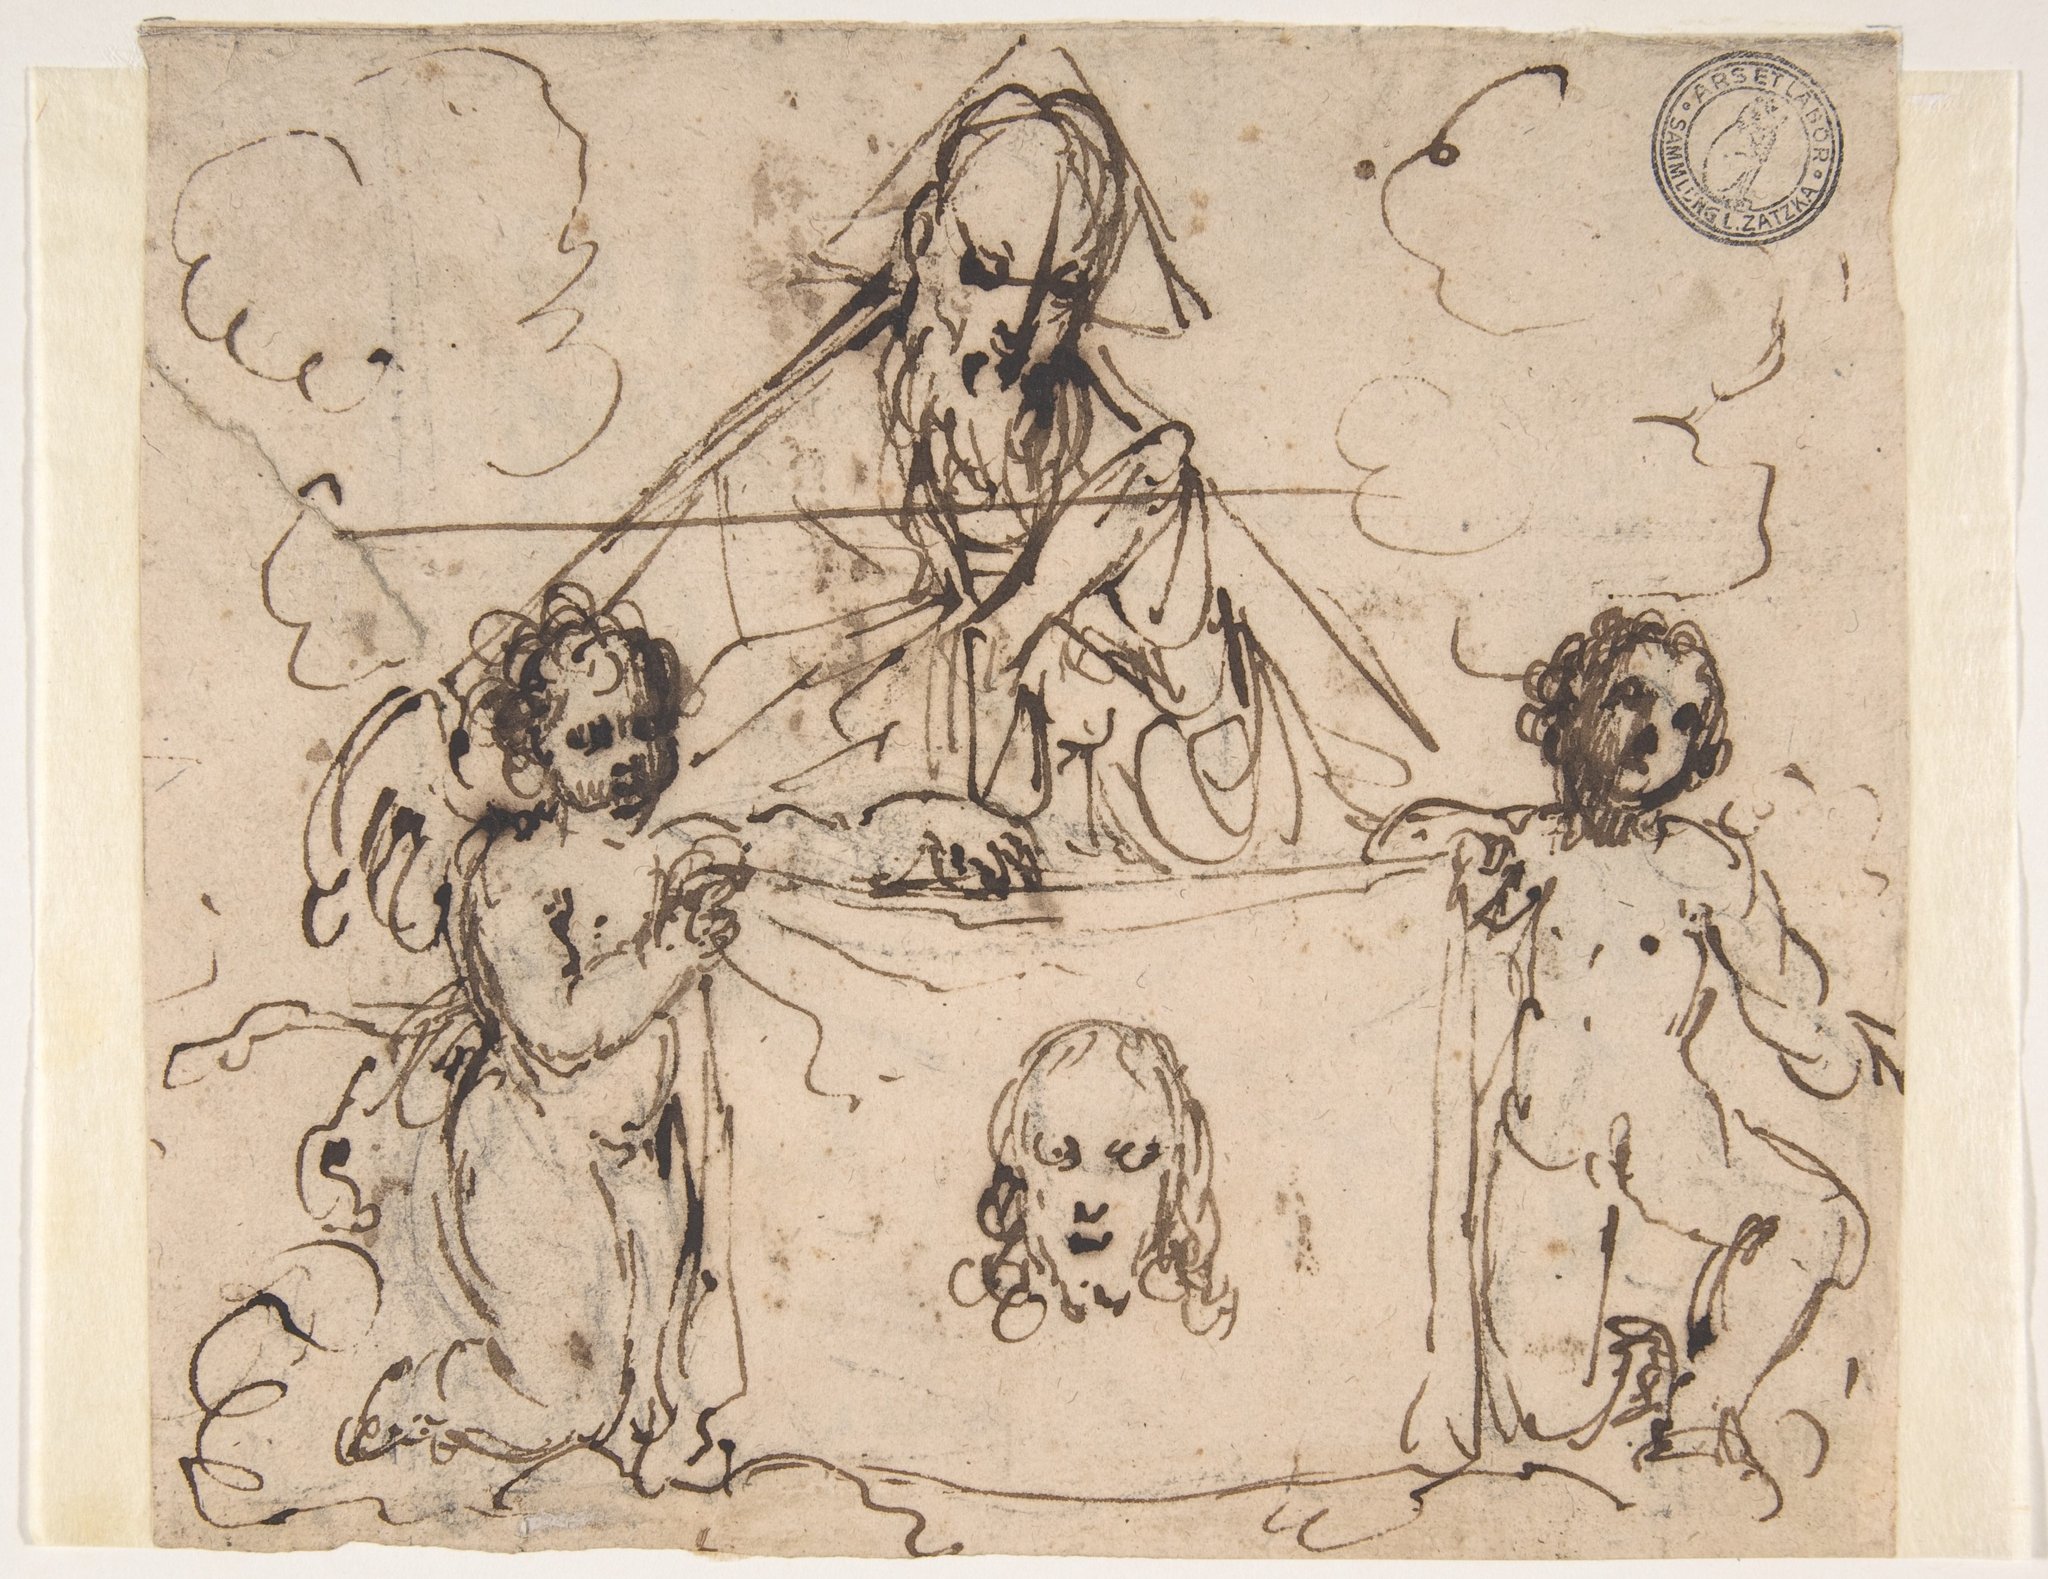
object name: drawing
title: Veronica's Veil Held by Two Angels and God the Father(?)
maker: anonymous, italian, bolognese, 17th century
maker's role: artist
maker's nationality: italian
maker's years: 1600-1700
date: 1601-1700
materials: charcoal, ink, paper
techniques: pen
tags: angels,god the father